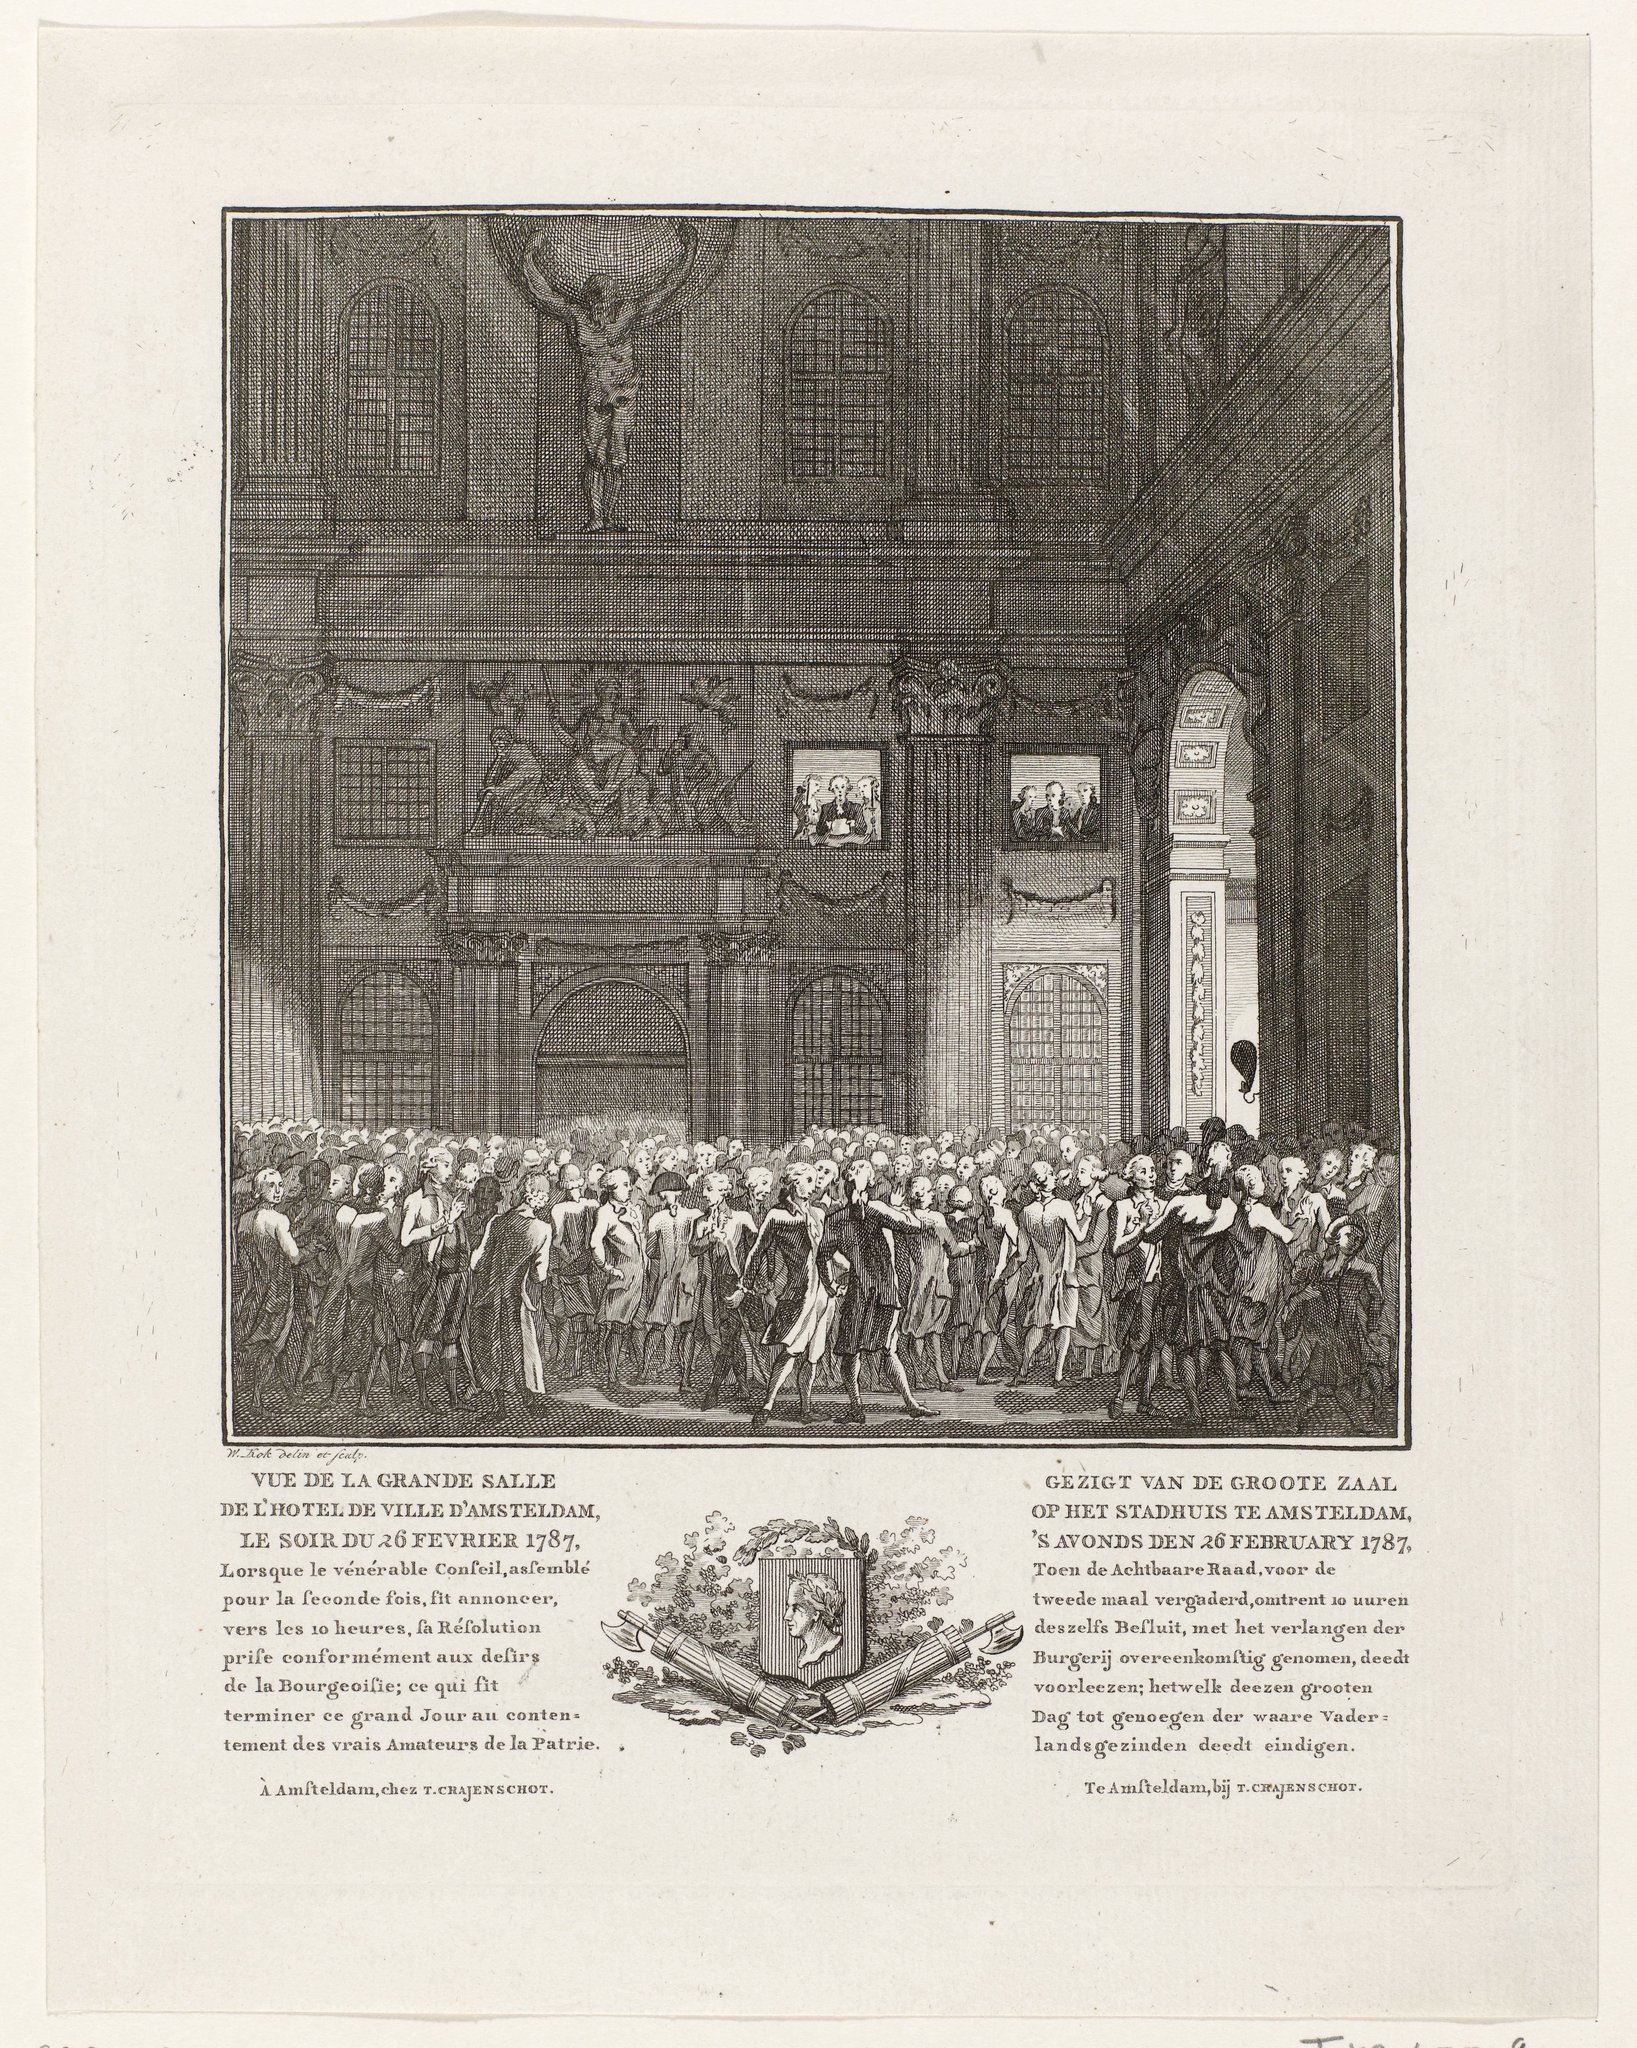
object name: print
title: Menigte in het Stadhuis op de Dam, 1787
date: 1787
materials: paper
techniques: engraving, etching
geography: amsterdam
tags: hendrik danielsz. hooft, announcement, proclamation of laws, crowd, mob, mayor, burgomaster, patriots (1780-1795)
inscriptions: collector's mark: Lugt 2228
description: Tevredenheid onder de samengestroomde menigte in de Burgerzaal van het Stadhuis op de Dam, tijdens de bekendmaking van het besluit van de raad in overeenstemming met het verlangen van de burgerij, 's avonds 26 februari 1787. In de marge de titels in het Frans en Nederlands aan weerszijden van het wapen van Hooft.